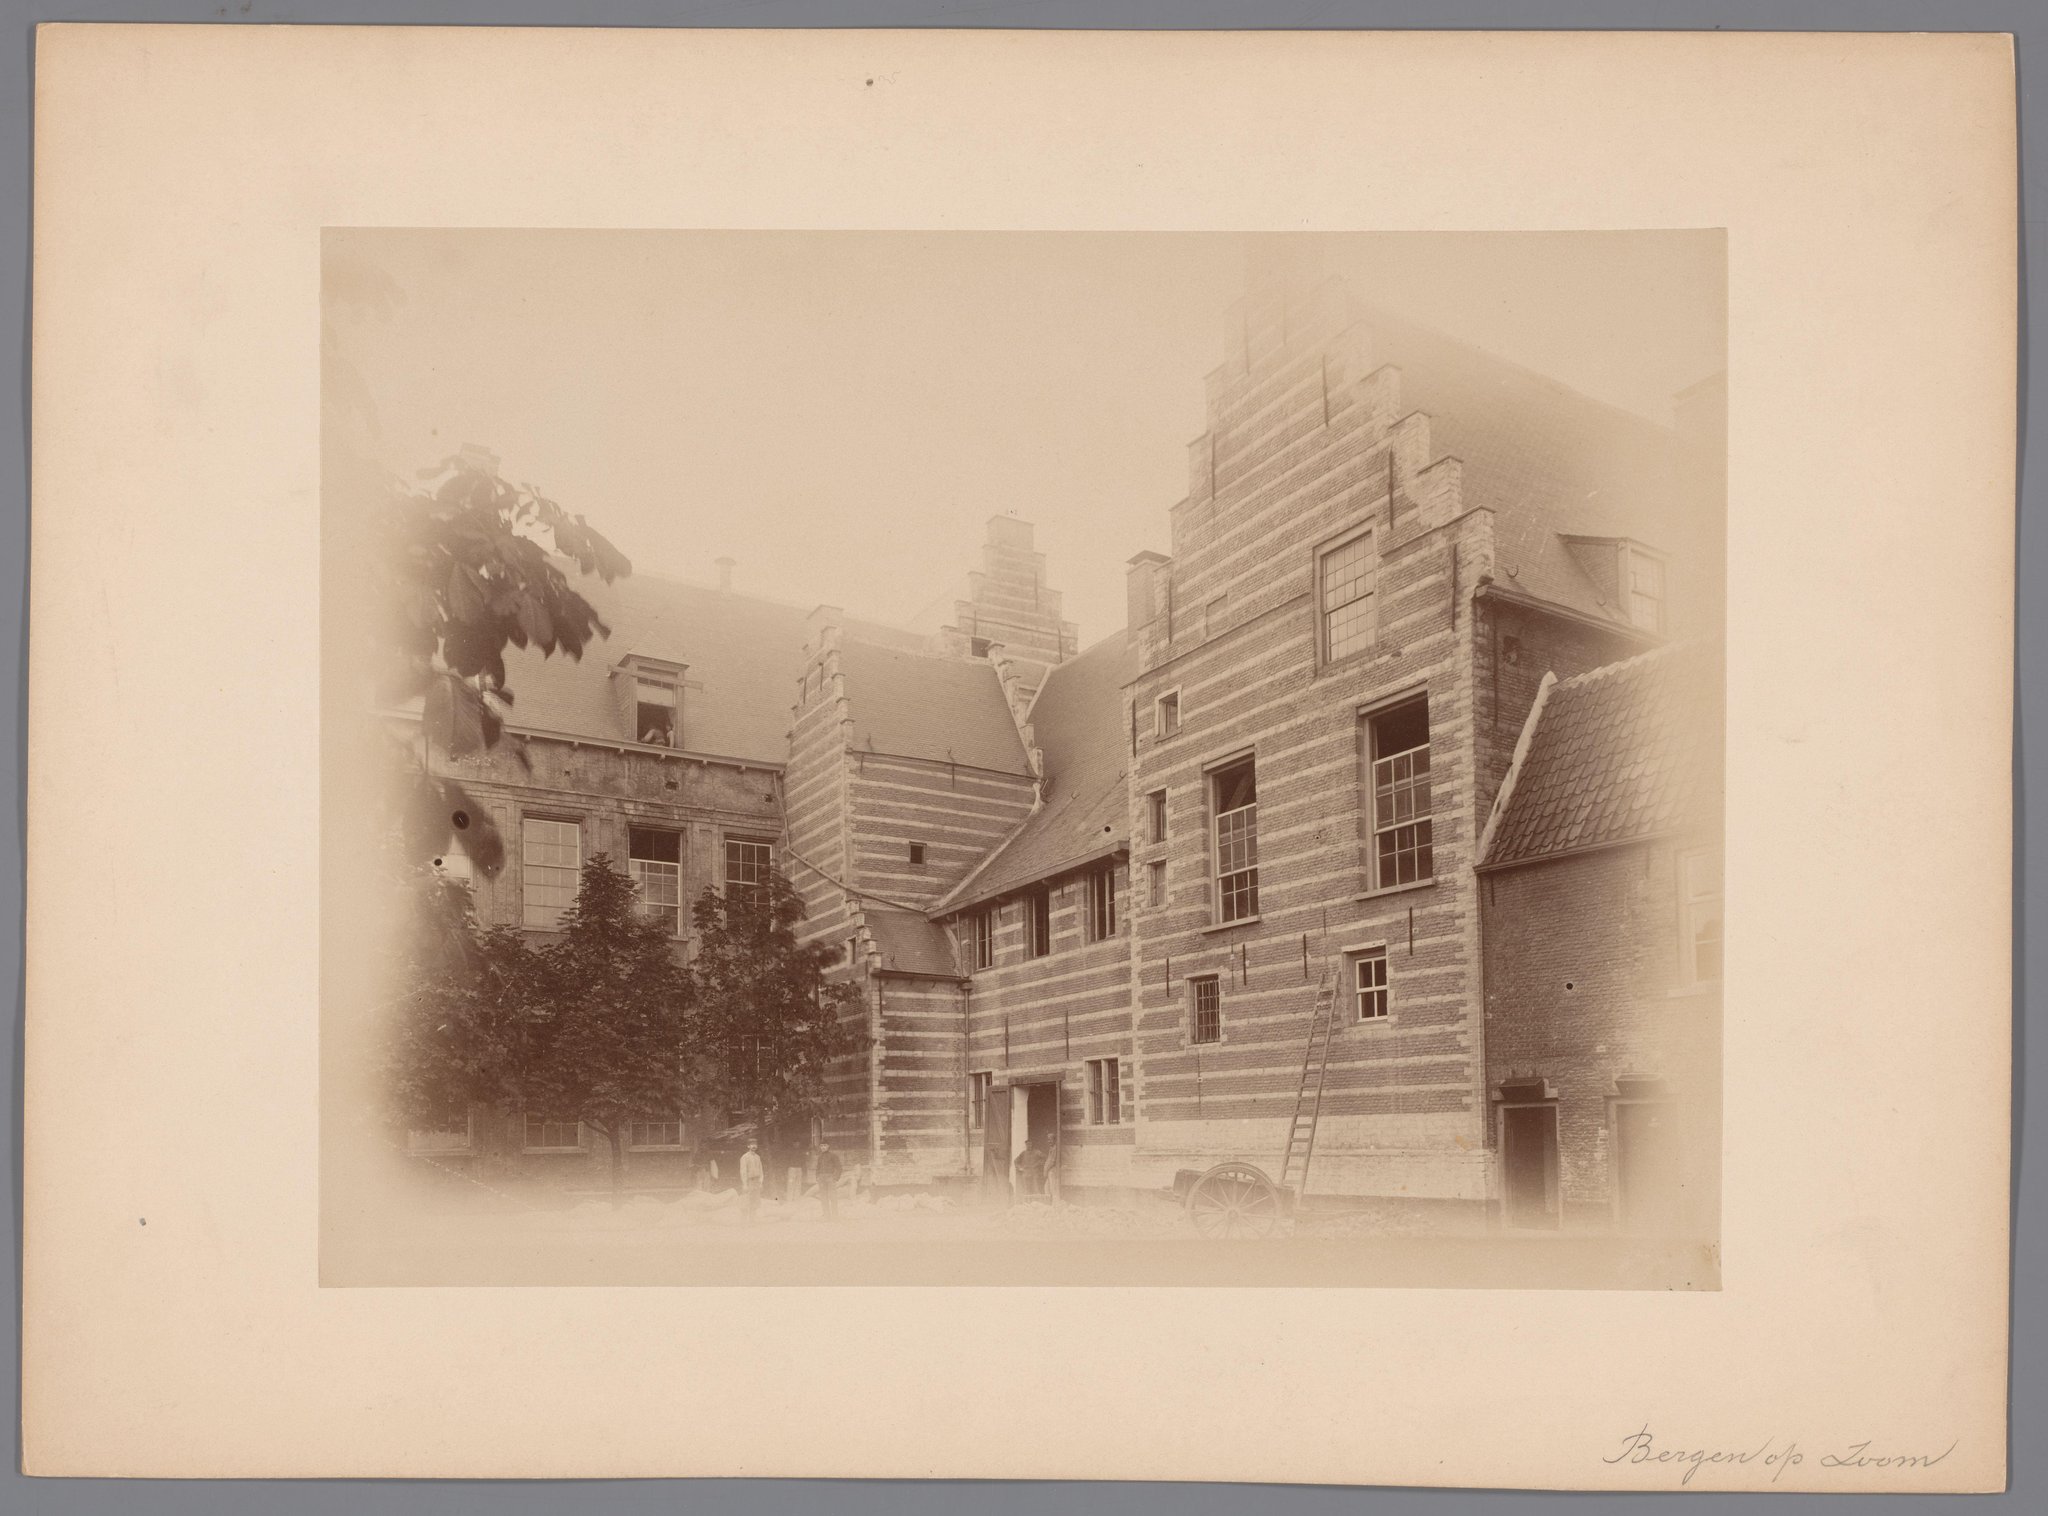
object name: photograph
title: Gevel op de achterplaats van het Markiezenhof te Bergen op Zoom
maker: anoniem (monumentenzorg)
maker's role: fotograaf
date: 1890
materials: cardboard, photographic support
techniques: albumen print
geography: bergen op zoom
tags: façade (of house or building), backyard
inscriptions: annotation: ‘Markiezenhof te Bergen-op-Zoom/ gevel op de groote achterplaats/ sept 1890’, annotation: ‘Bergen op Zoom’